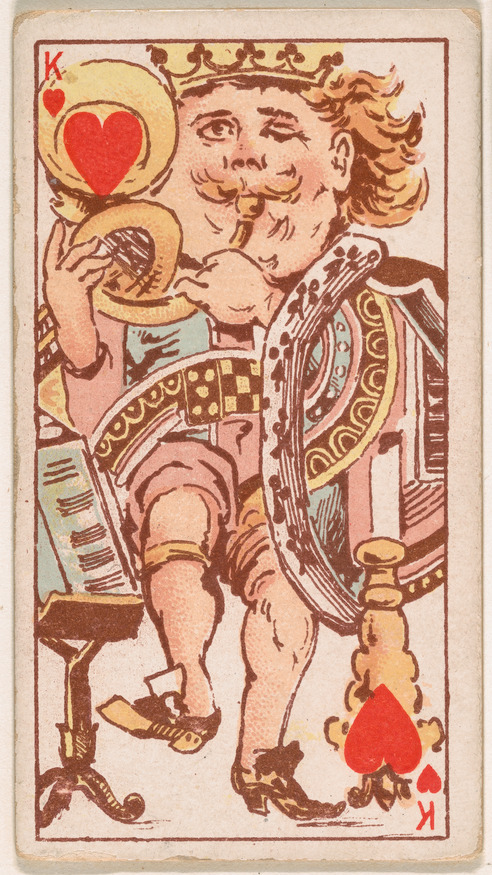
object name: print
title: King of Hearts, from Harlequin Cards, 2nd Series (N220) issued by Kinney Bros.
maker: kinney brothers tobacco company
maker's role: publisher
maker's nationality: american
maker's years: 1869-2011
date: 1889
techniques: color lithograph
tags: men,playing cards,horns